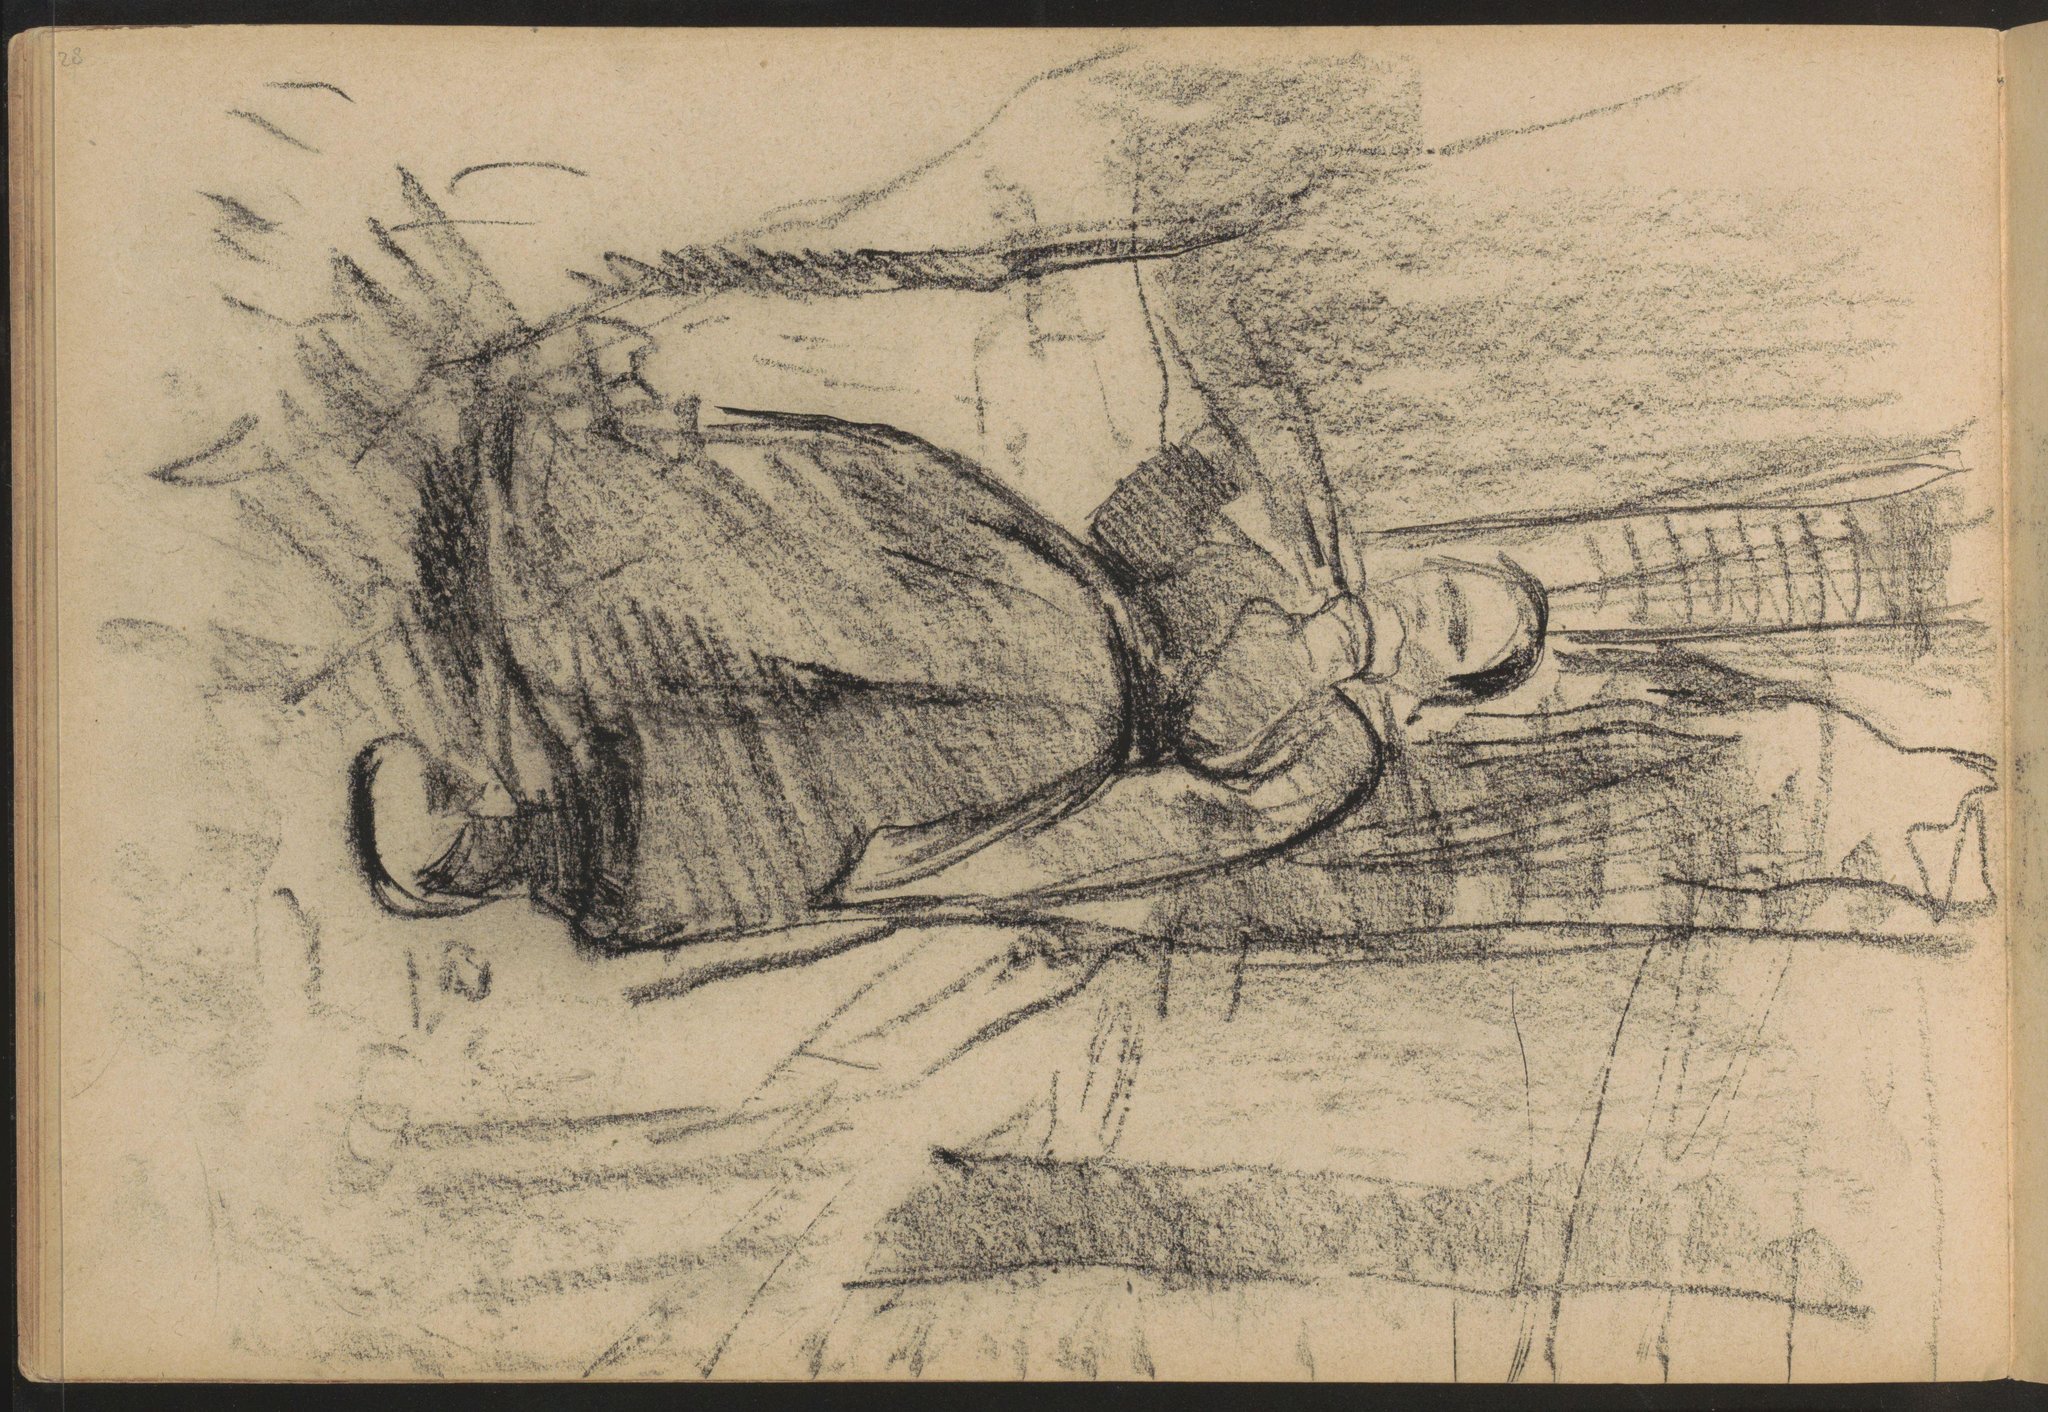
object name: sketchbook leaf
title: Jonge vrouw met takkenbos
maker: willem witsen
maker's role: draughtsman, painter, print maker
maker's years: 1860-1923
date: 1884-1887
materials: chalk, paper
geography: ewijkshoeve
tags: trees (+ bundle of twigs, faggot), adolescent, young woman, maiden, forest, wood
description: Voorstudie voor de ets 'Jonge vrouw met takkenbos'. ca. 1886.